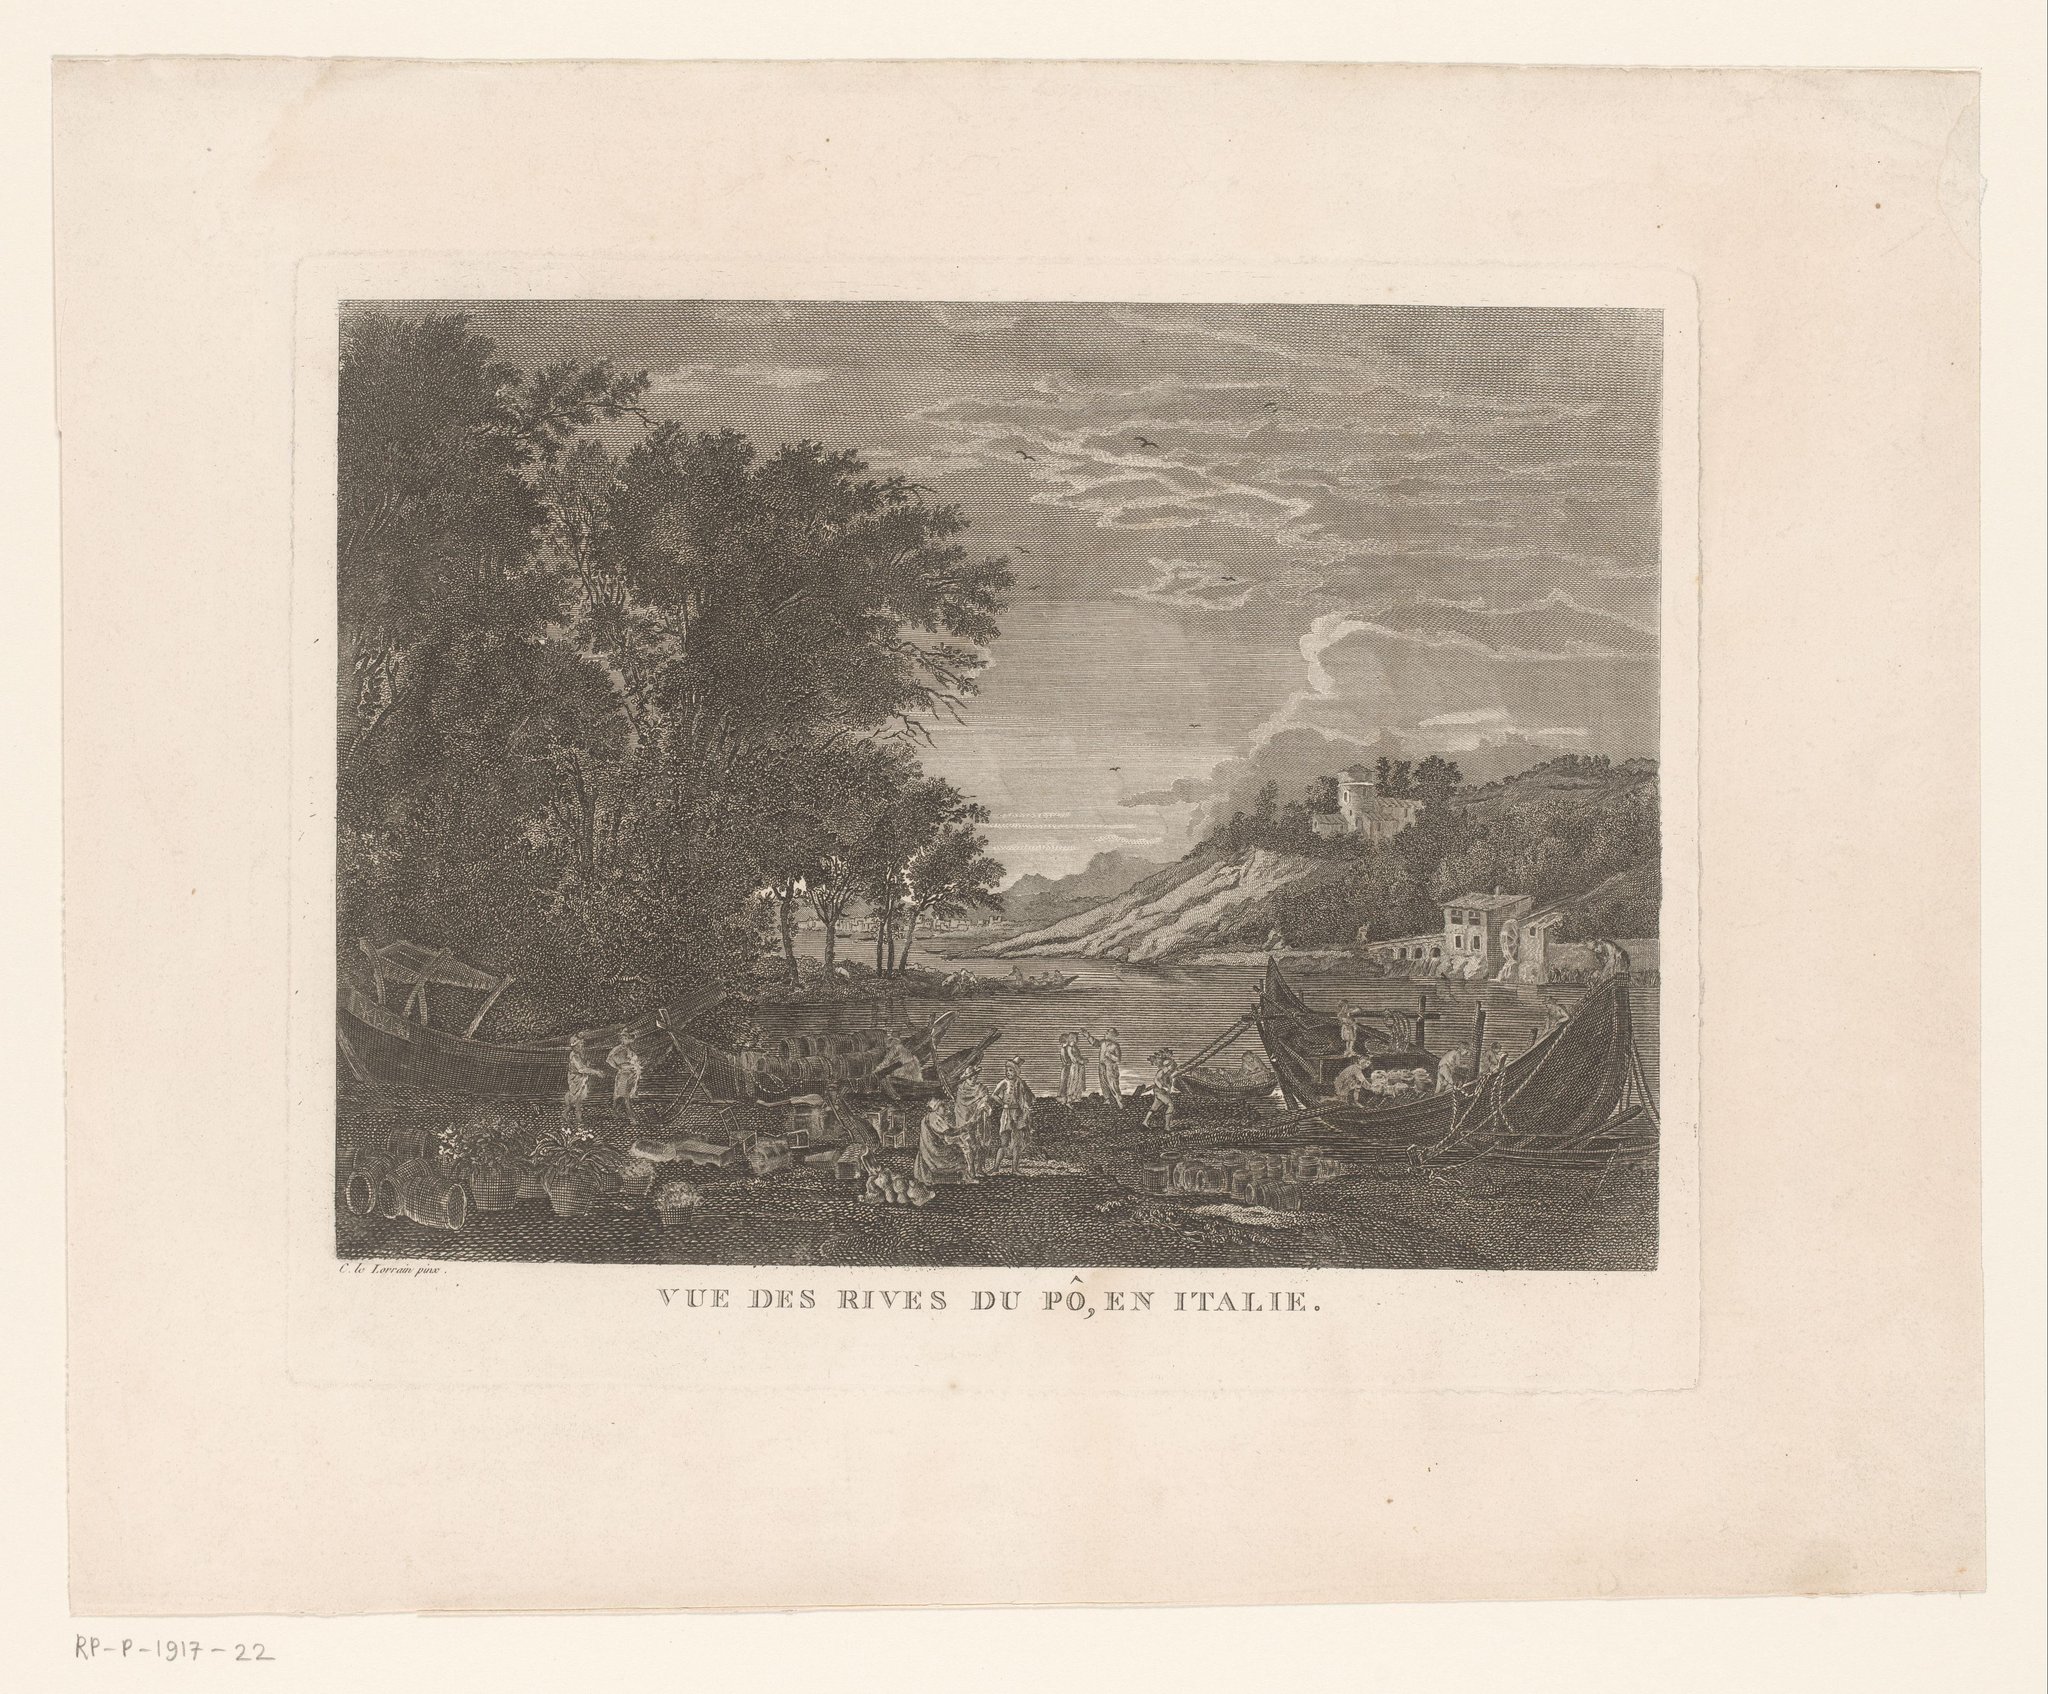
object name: print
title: Vue des Rives du Pô, en Italie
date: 1750-1850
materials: paper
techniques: etching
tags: river, harbouring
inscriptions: collector's mark: Lugt 2228